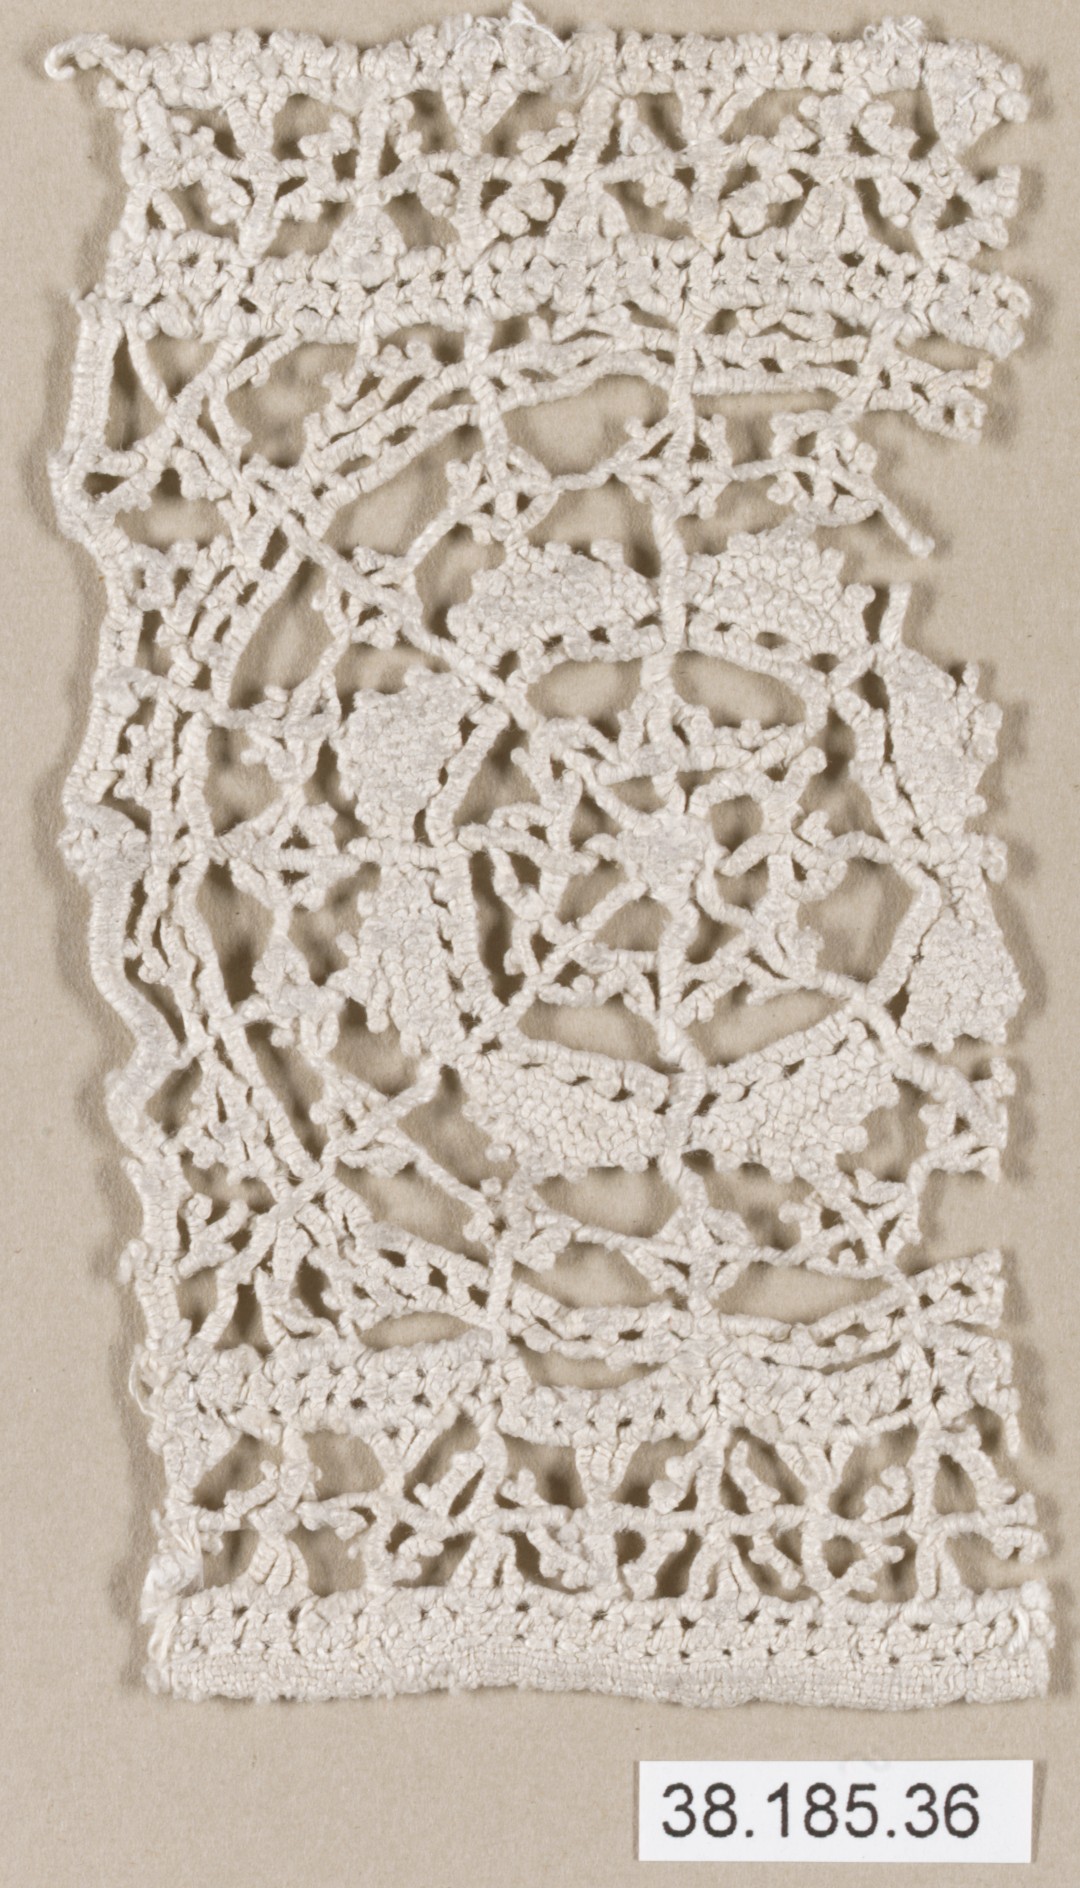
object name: piece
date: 1501-1700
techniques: embroidery